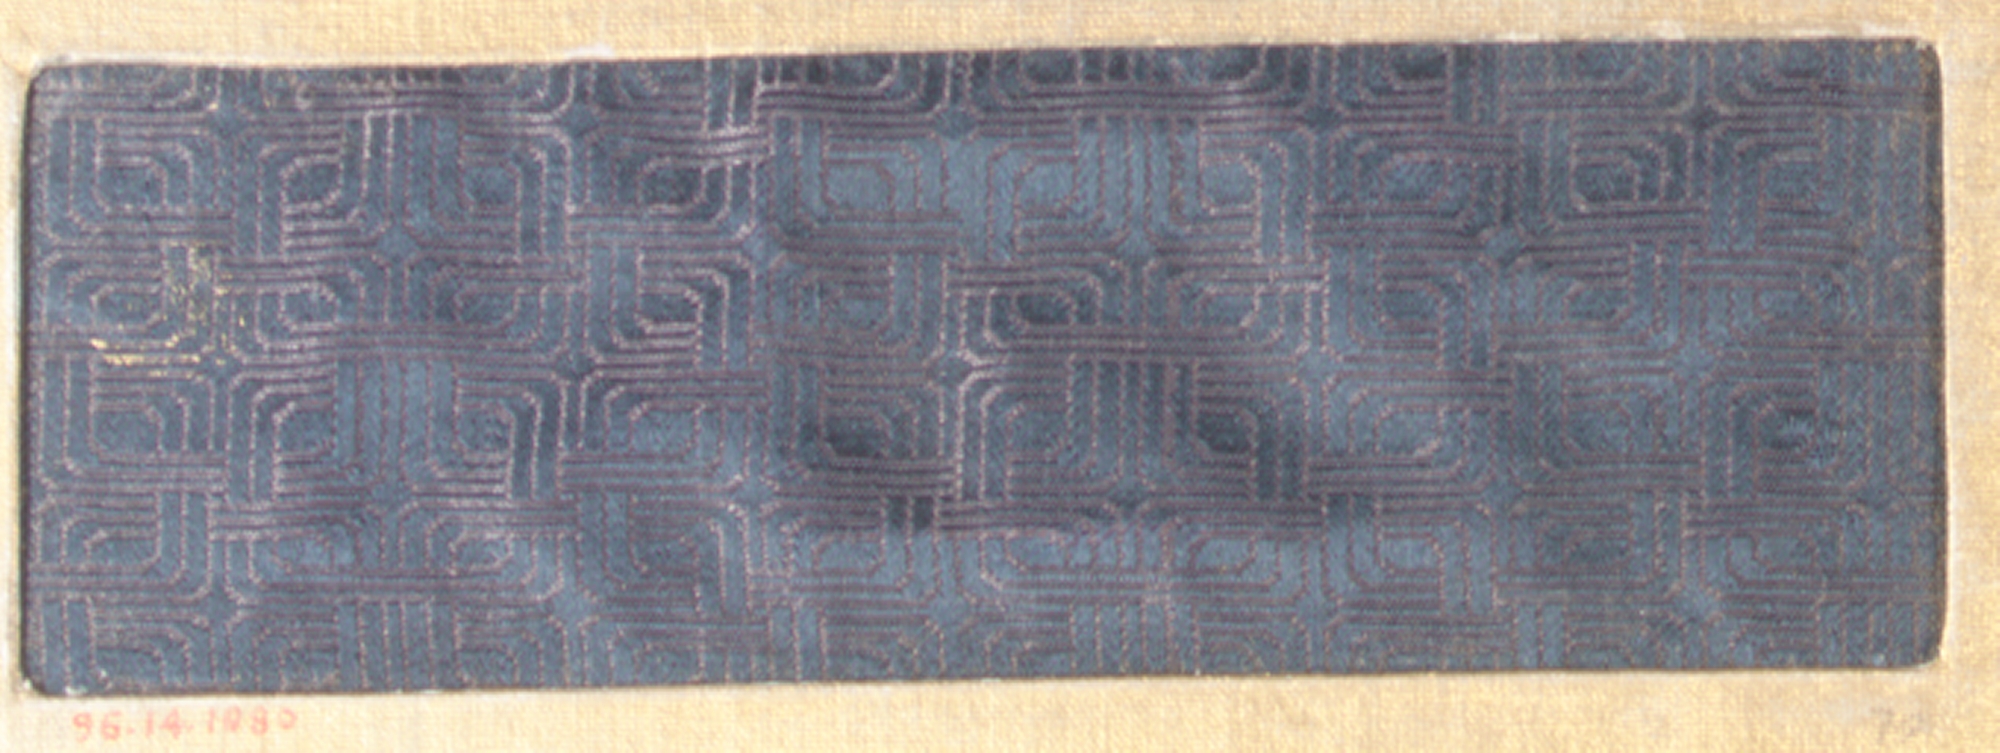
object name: piece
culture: japanese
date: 1701-1900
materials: silk